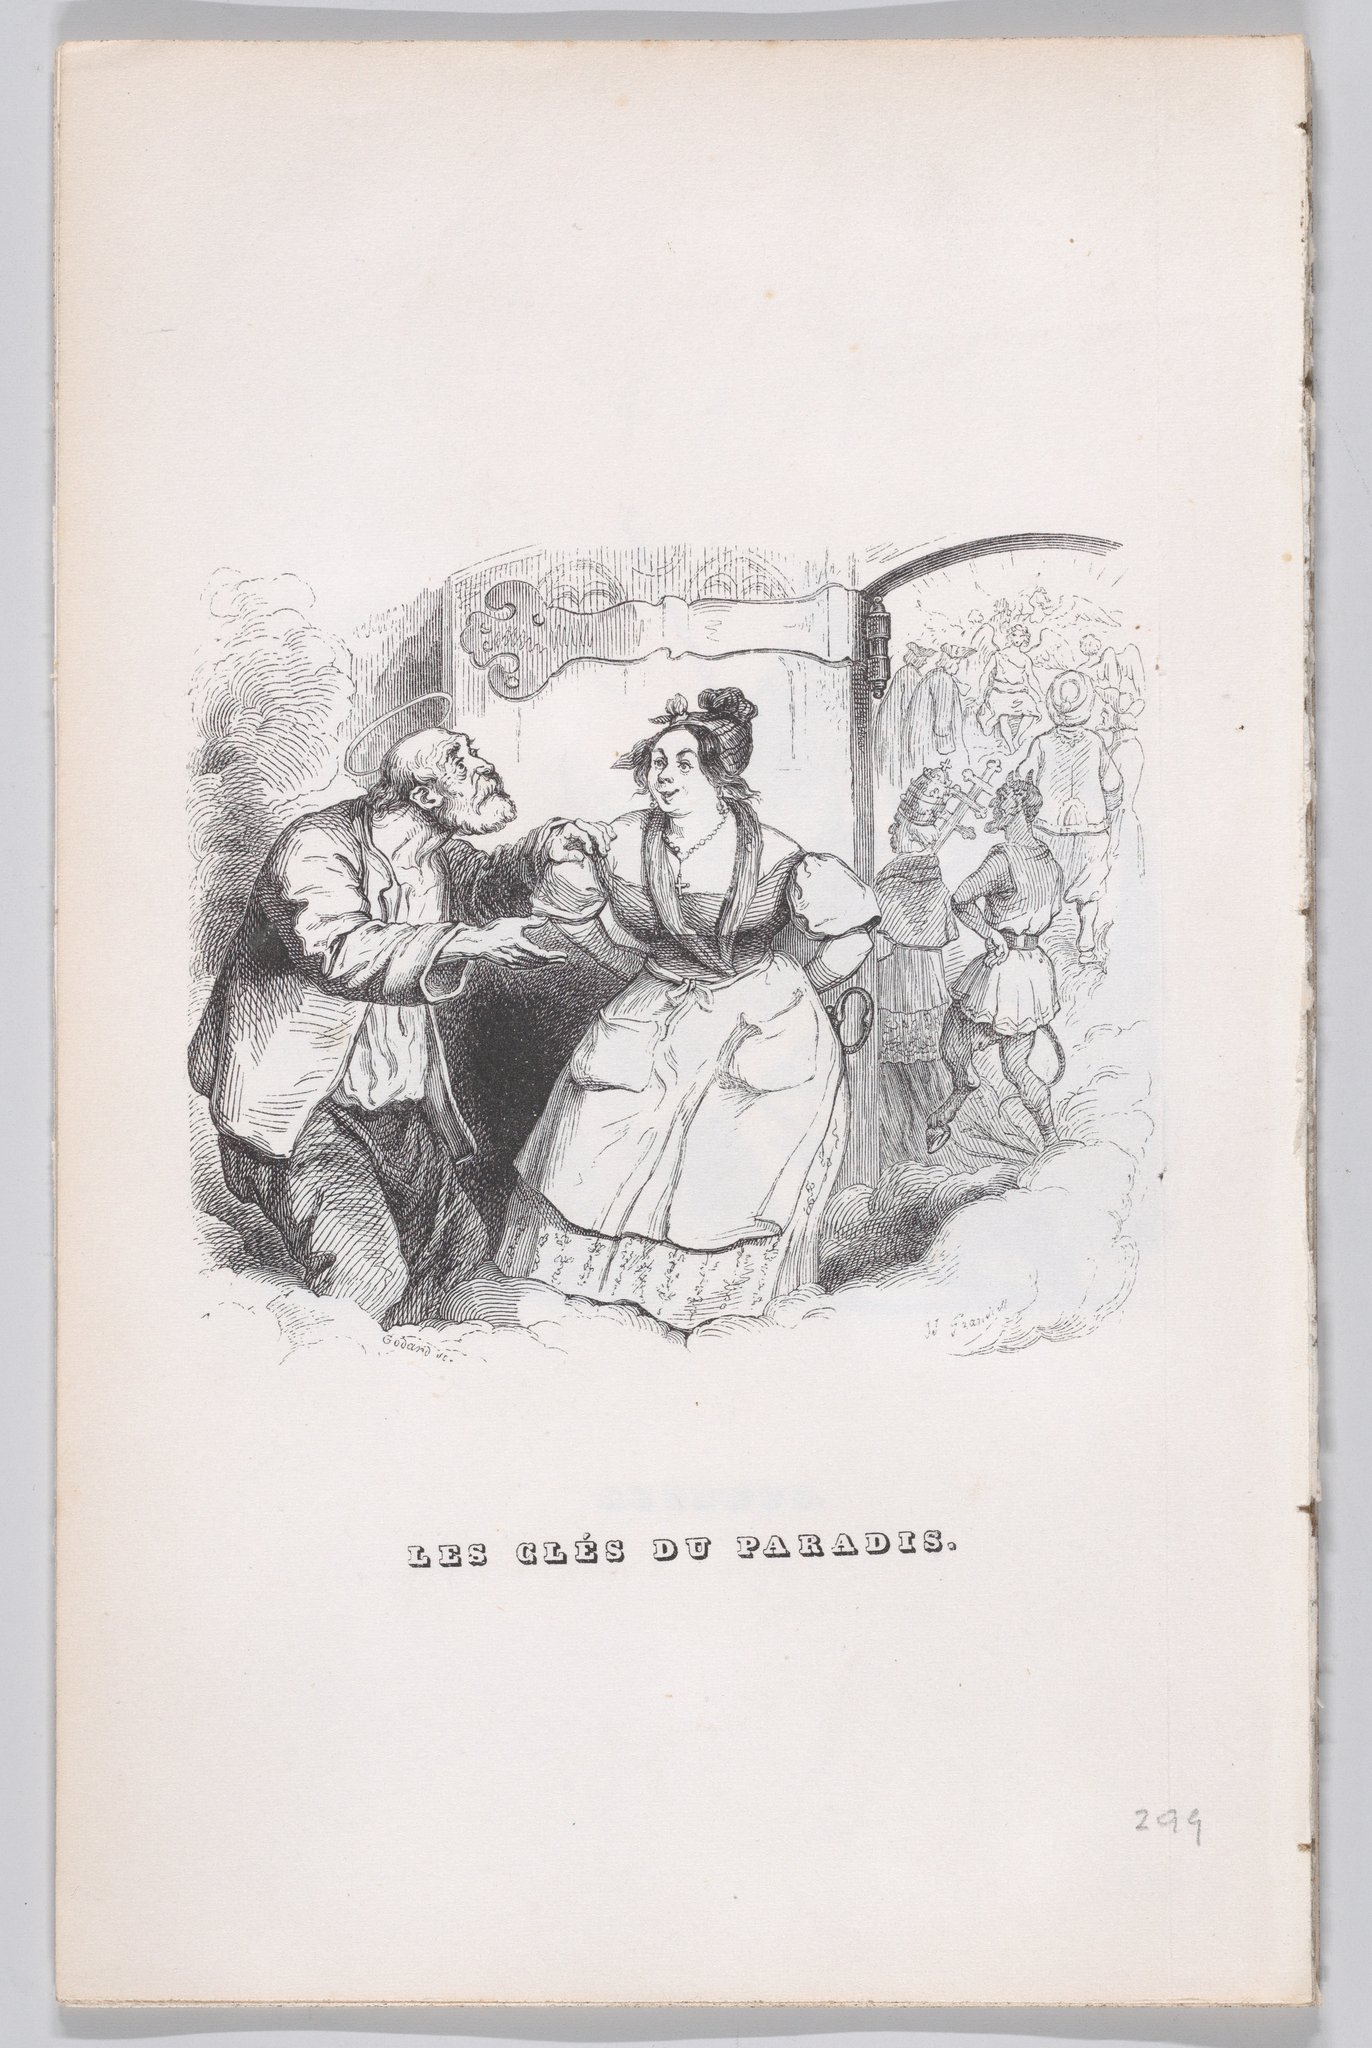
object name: print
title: The Keys to Paradise, from "The Complete Works of Béranger"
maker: j. j. grandville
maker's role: illustrator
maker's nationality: french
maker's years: 1803-1847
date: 1836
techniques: engraving